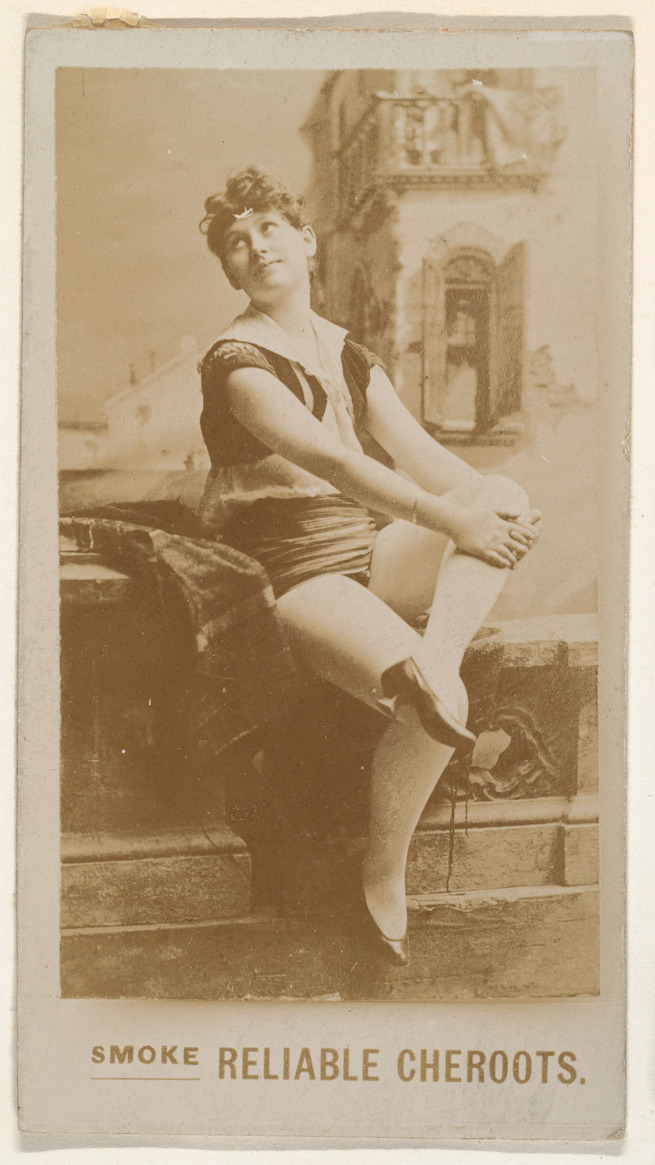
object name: photograph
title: Actress seated with hands on knee, from the Actresses series (N666) to promote Reliable Cheroots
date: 1888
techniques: albumen silver print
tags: portraits,women,actresses